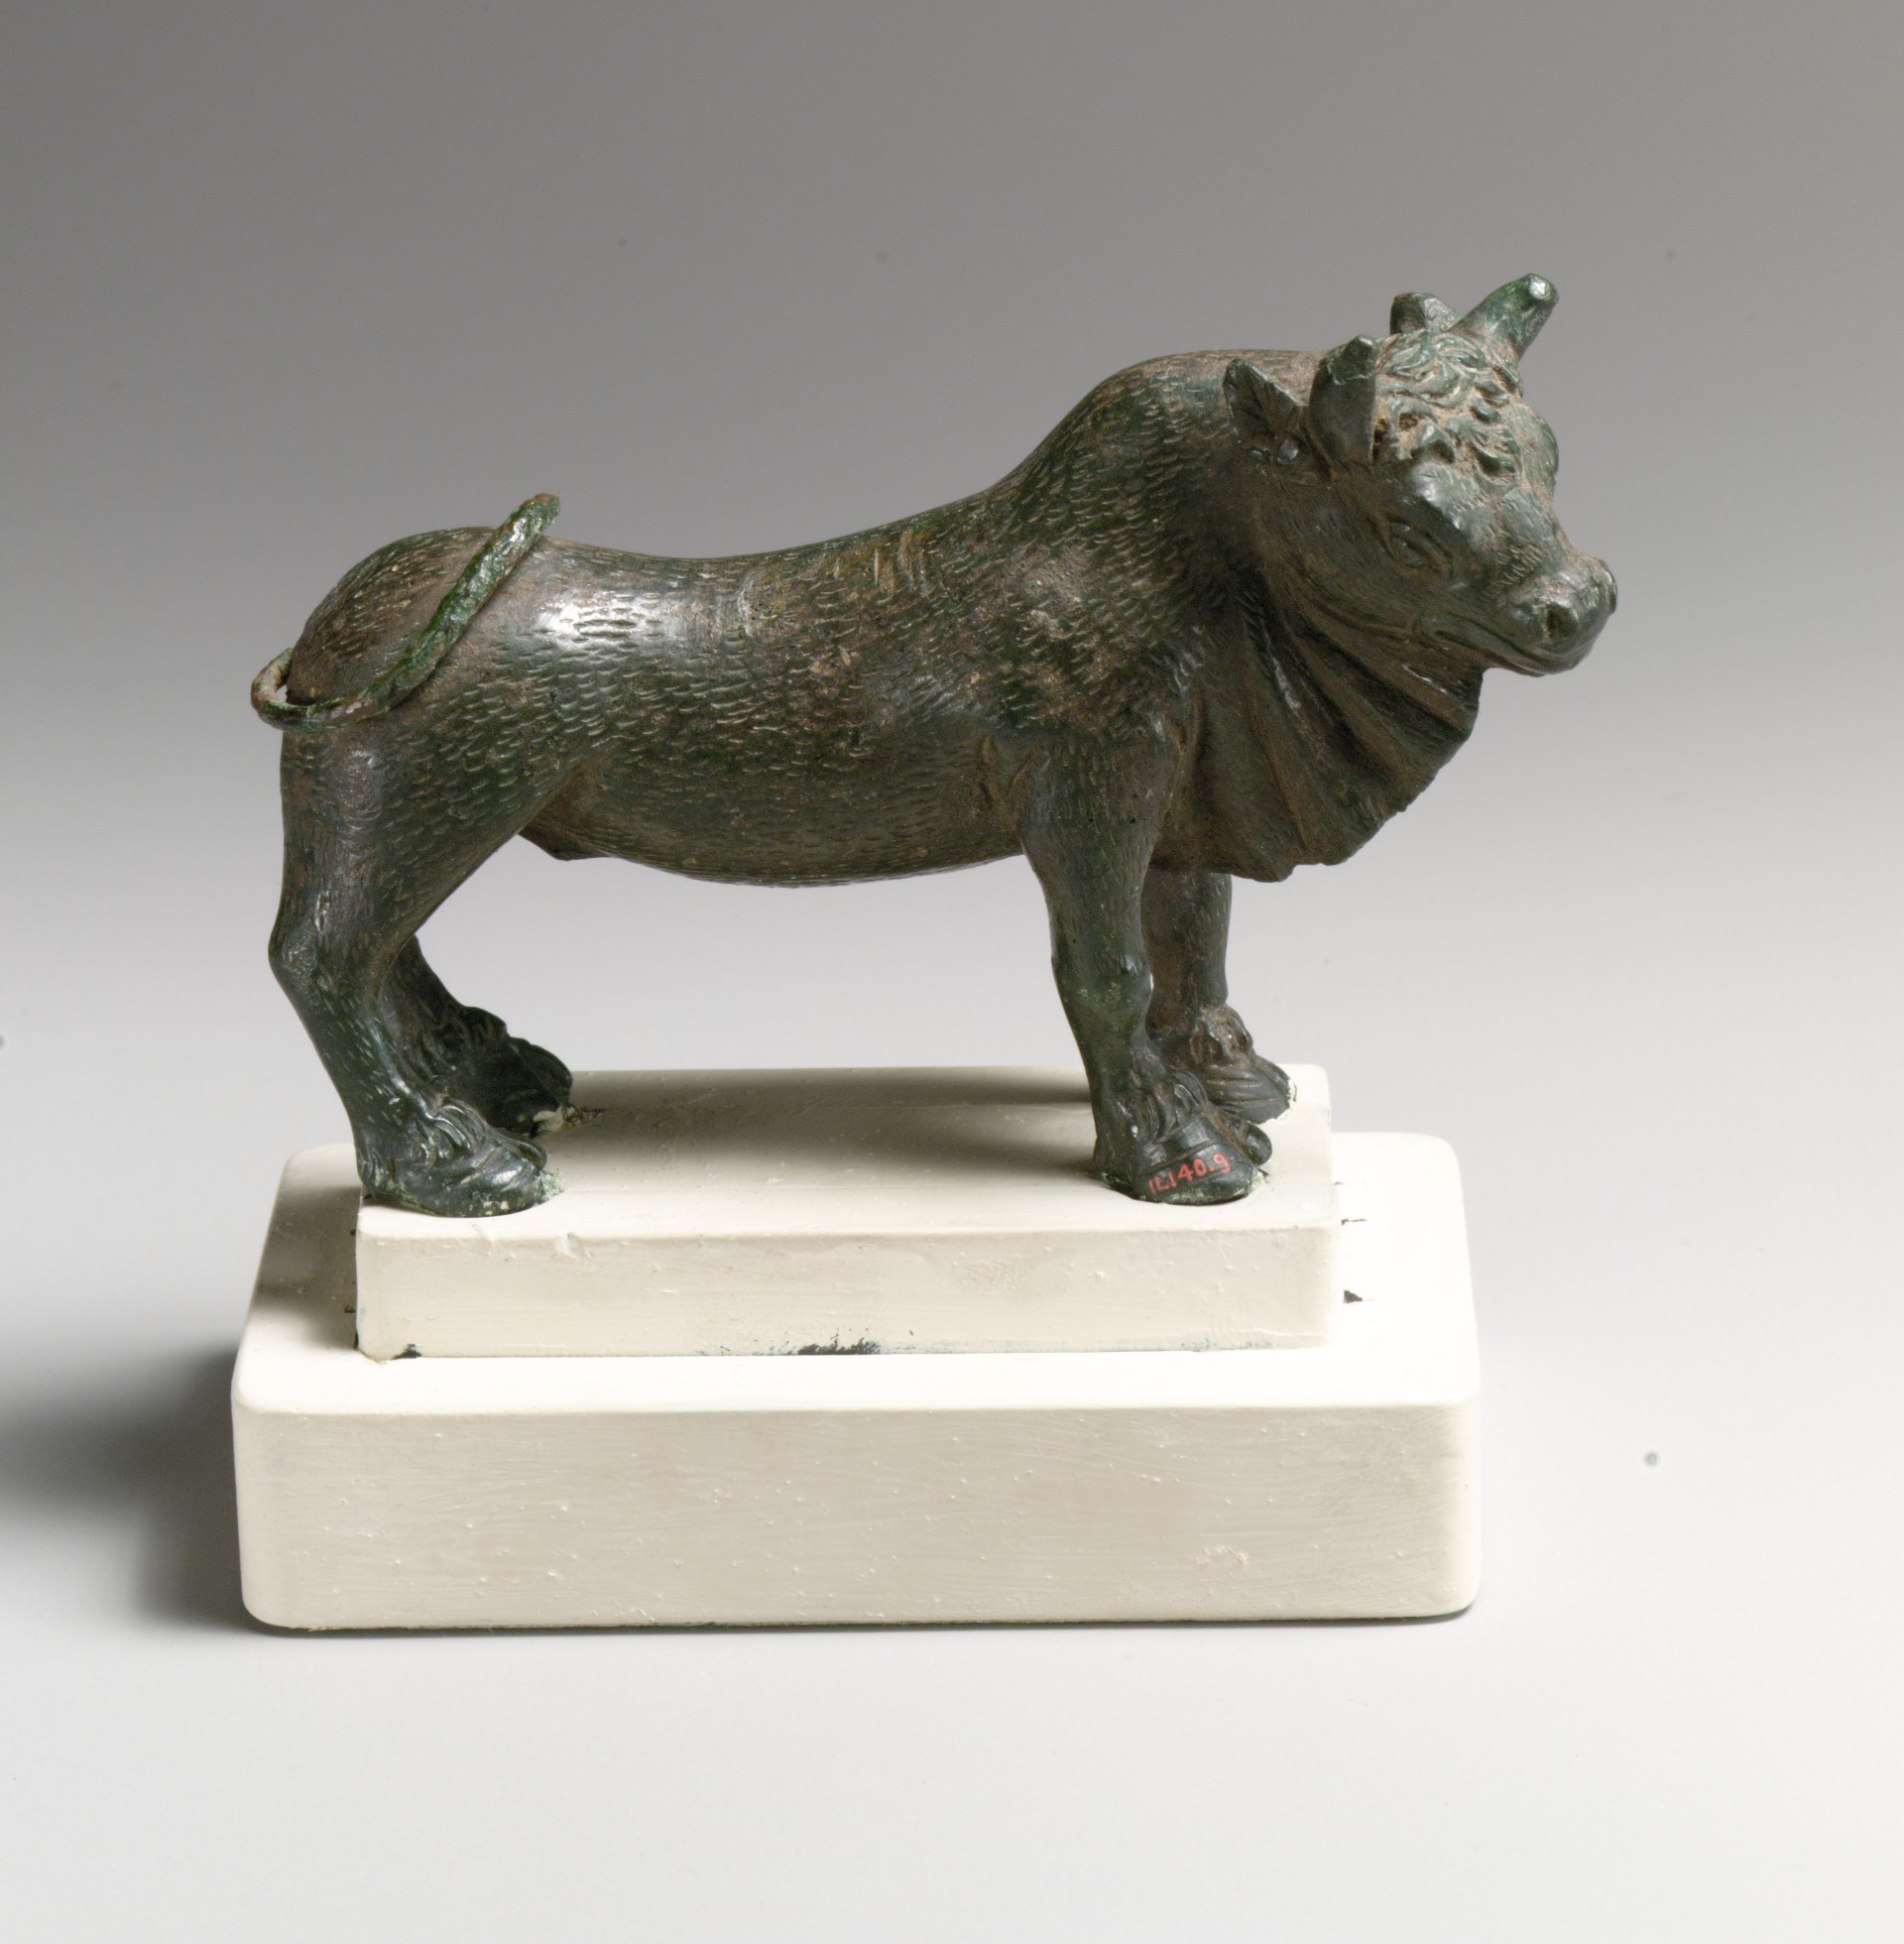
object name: statuette of a bull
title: Bronze statuette of a bull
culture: roman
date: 101-200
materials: bronze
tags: bulls